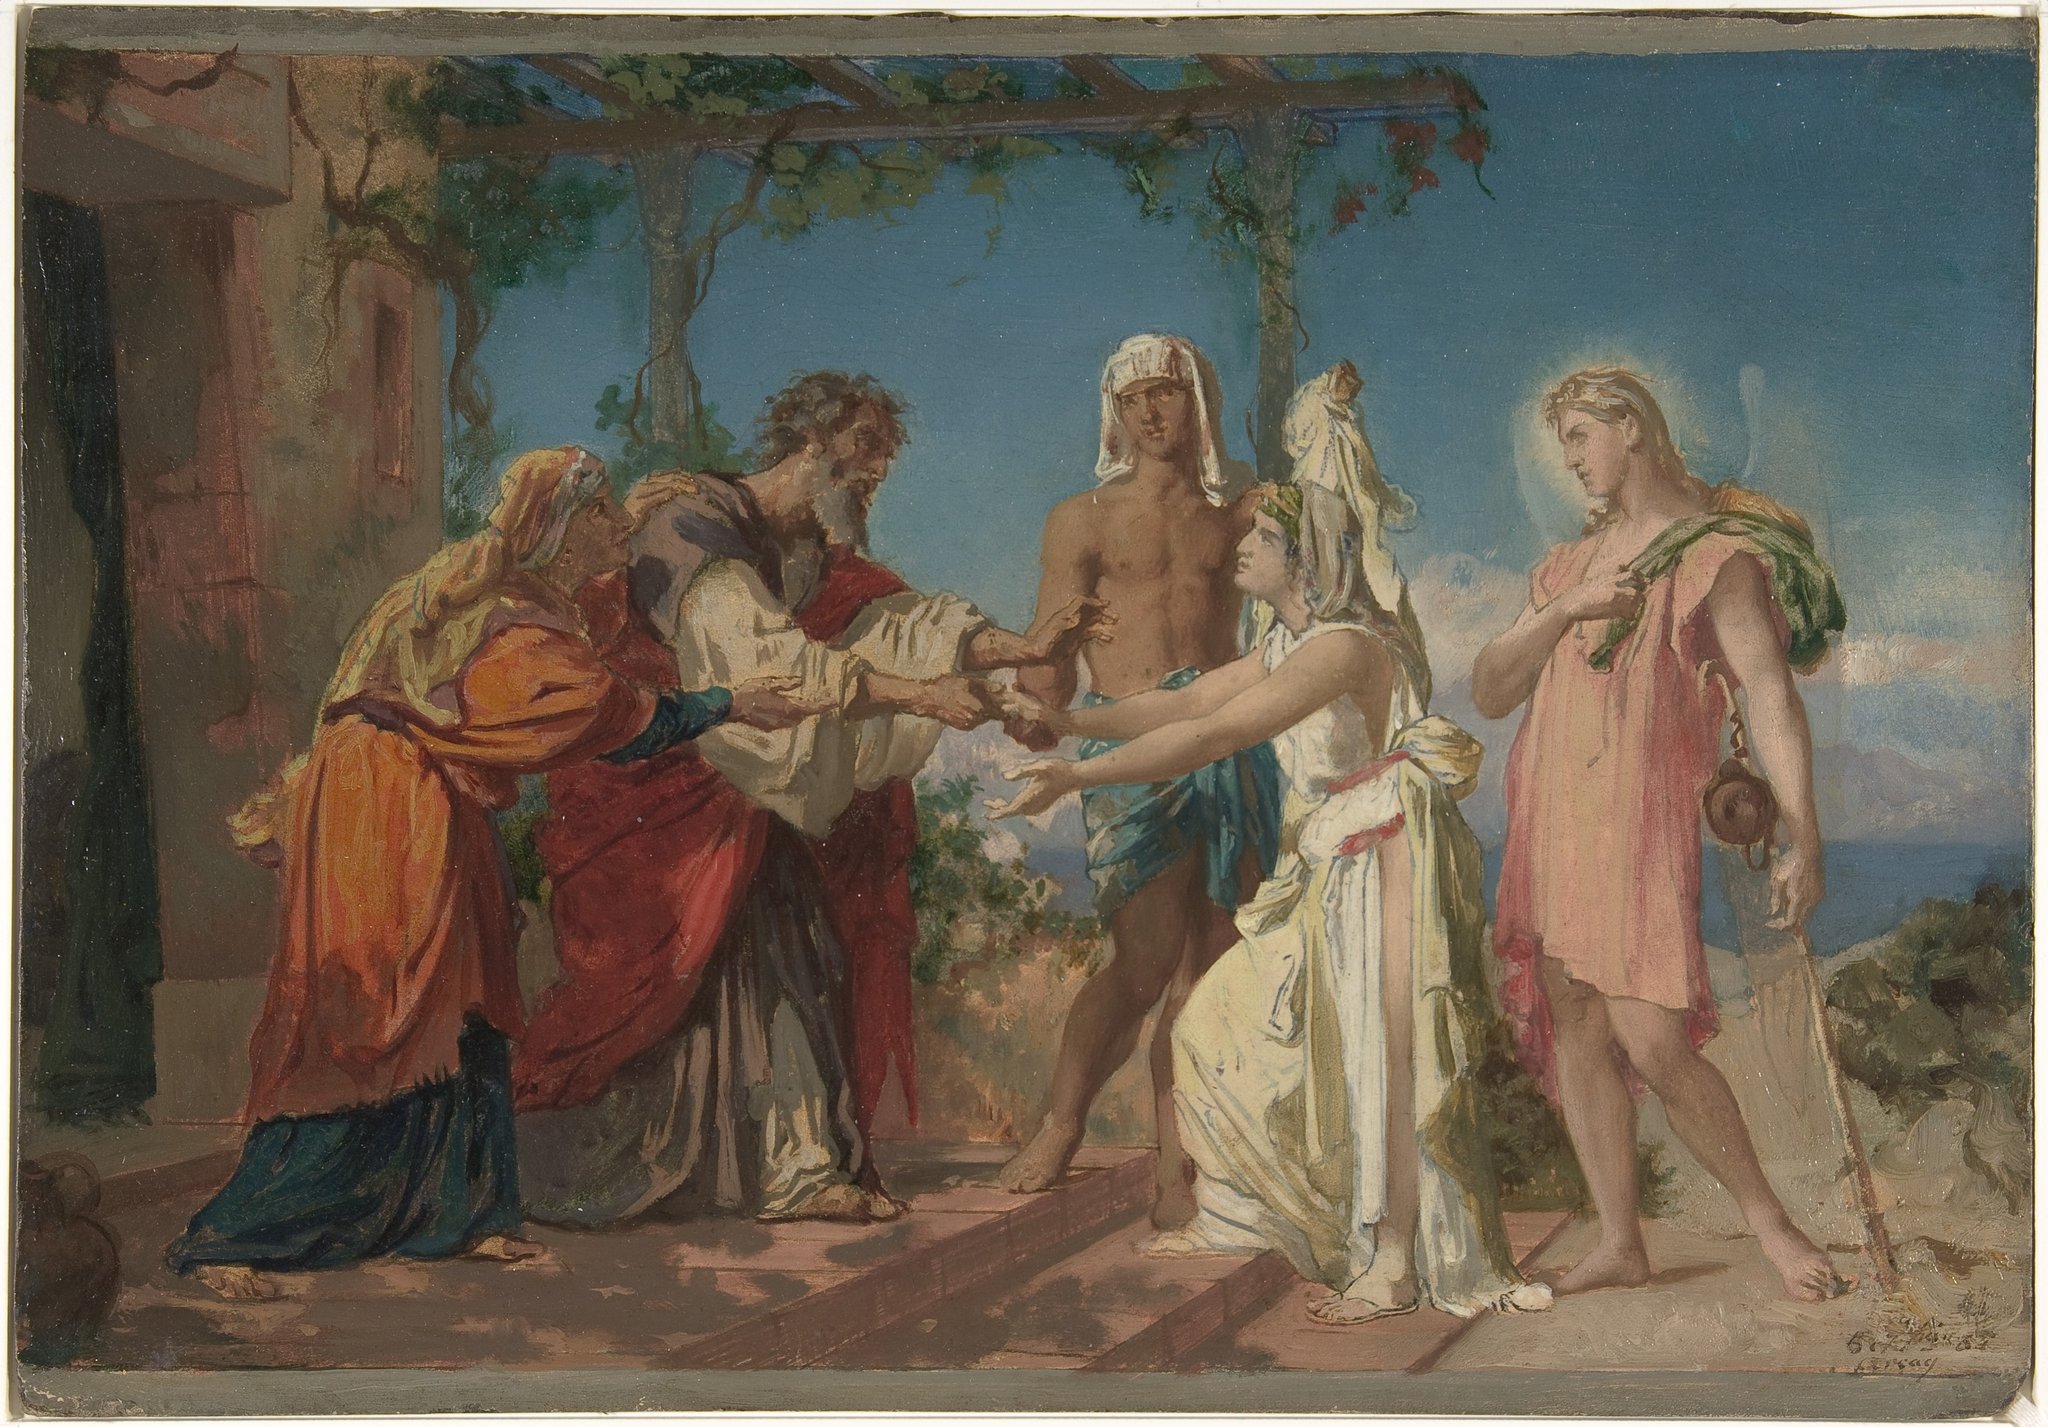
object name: drawing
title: Tobias Brings His Bride Sarah to the House of His Father, Tobit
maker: henri lehmann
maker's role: artist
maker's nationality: french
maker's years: 1814-1882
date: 1830-1882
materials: board, oil, paper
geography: france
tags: houses,men,women